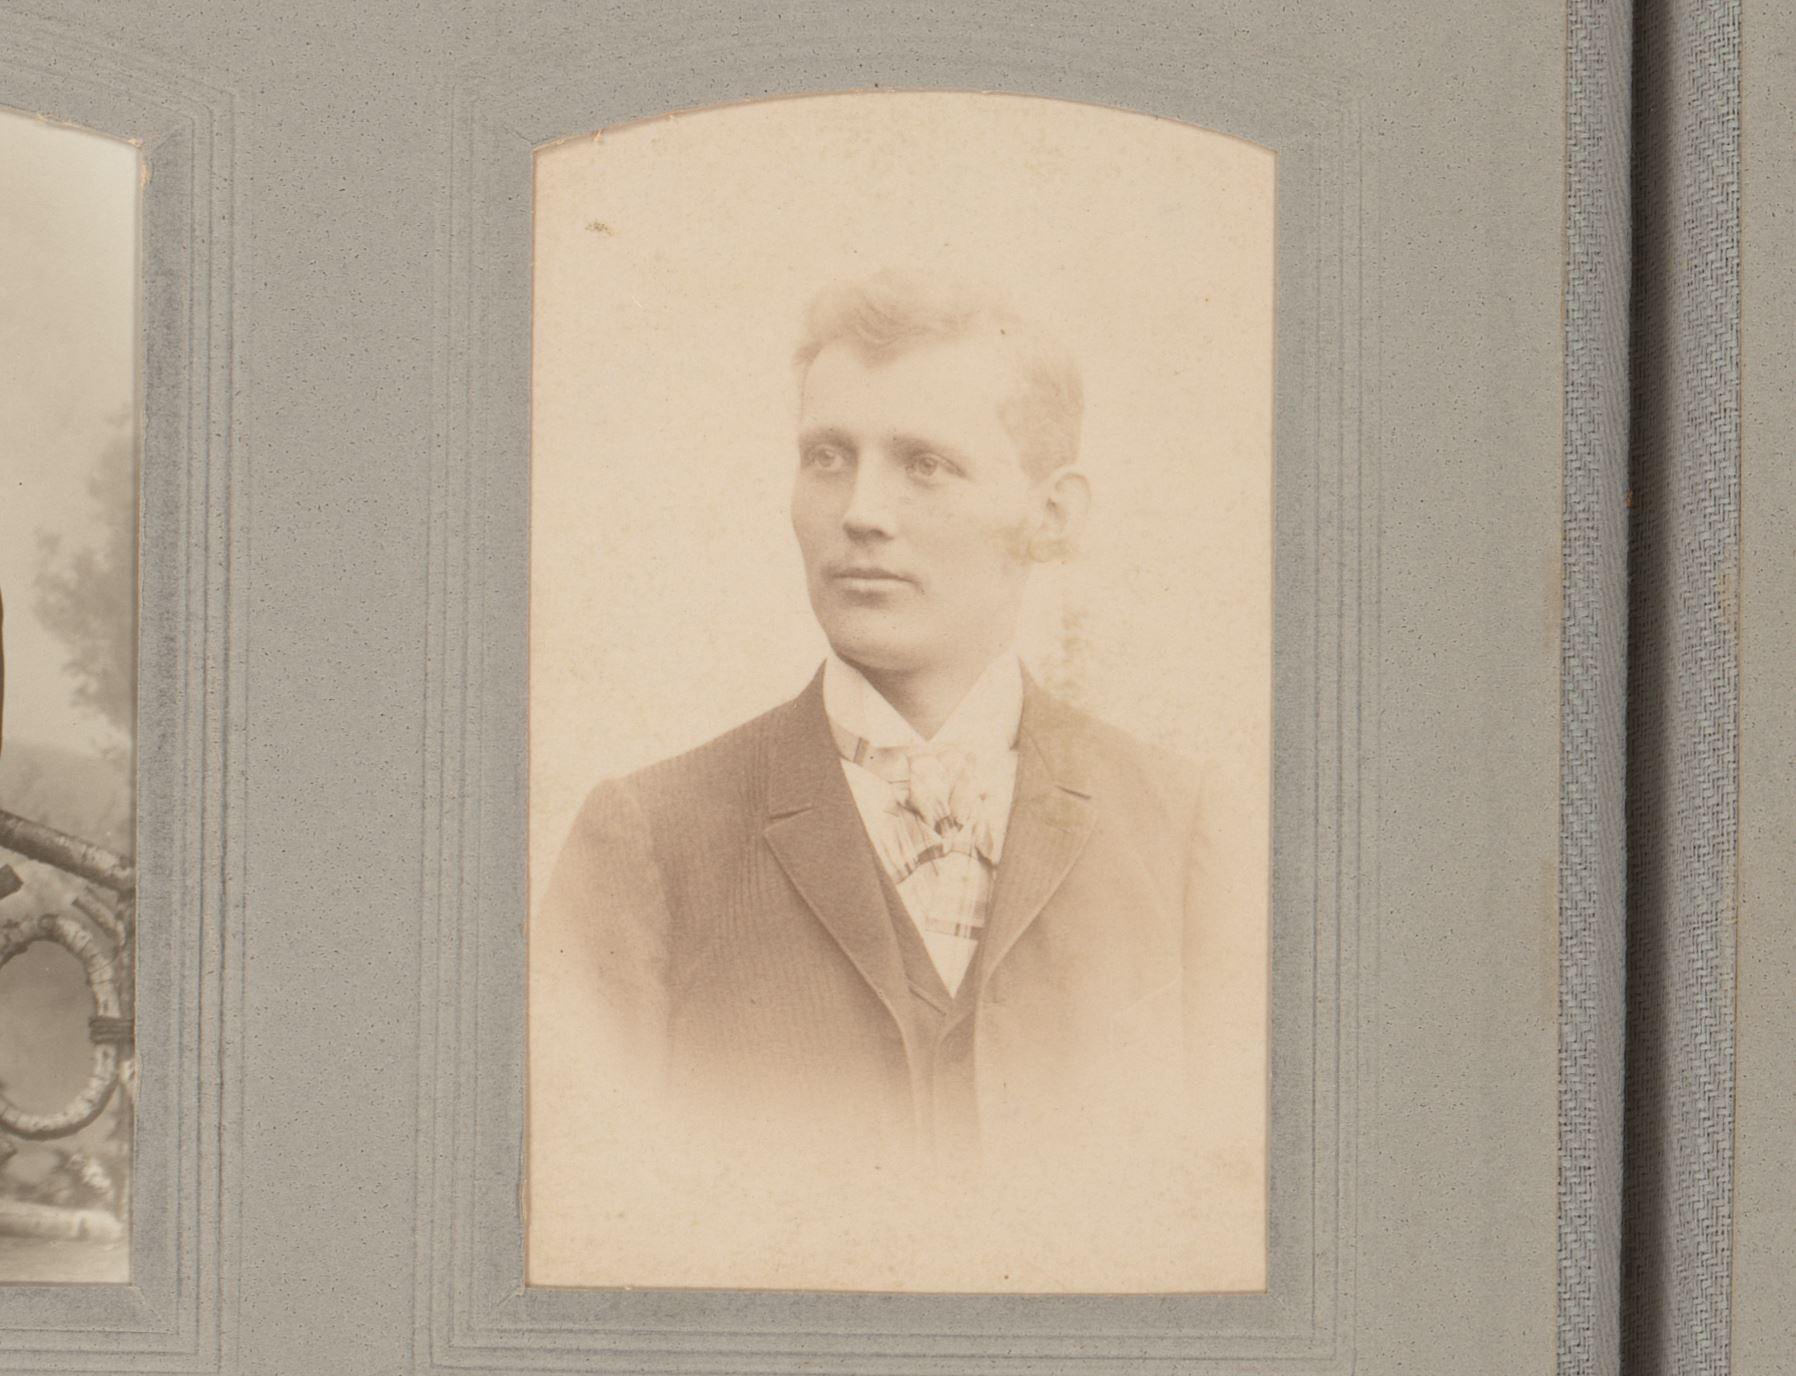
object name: photograph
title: Portret van een jonge man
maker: daniel nyblin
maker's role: fotograaf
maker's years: 1856-1923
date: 1860-1900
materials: cardboard, photographic support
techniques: albumen print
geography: helsinki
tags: historical persons, youth, adolescent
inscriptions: inscription: ‘D. Nyblin/ Helsingfors/ Helsinissä Fabianinkatu No 31./ (...)/ Plåten förvaras.’